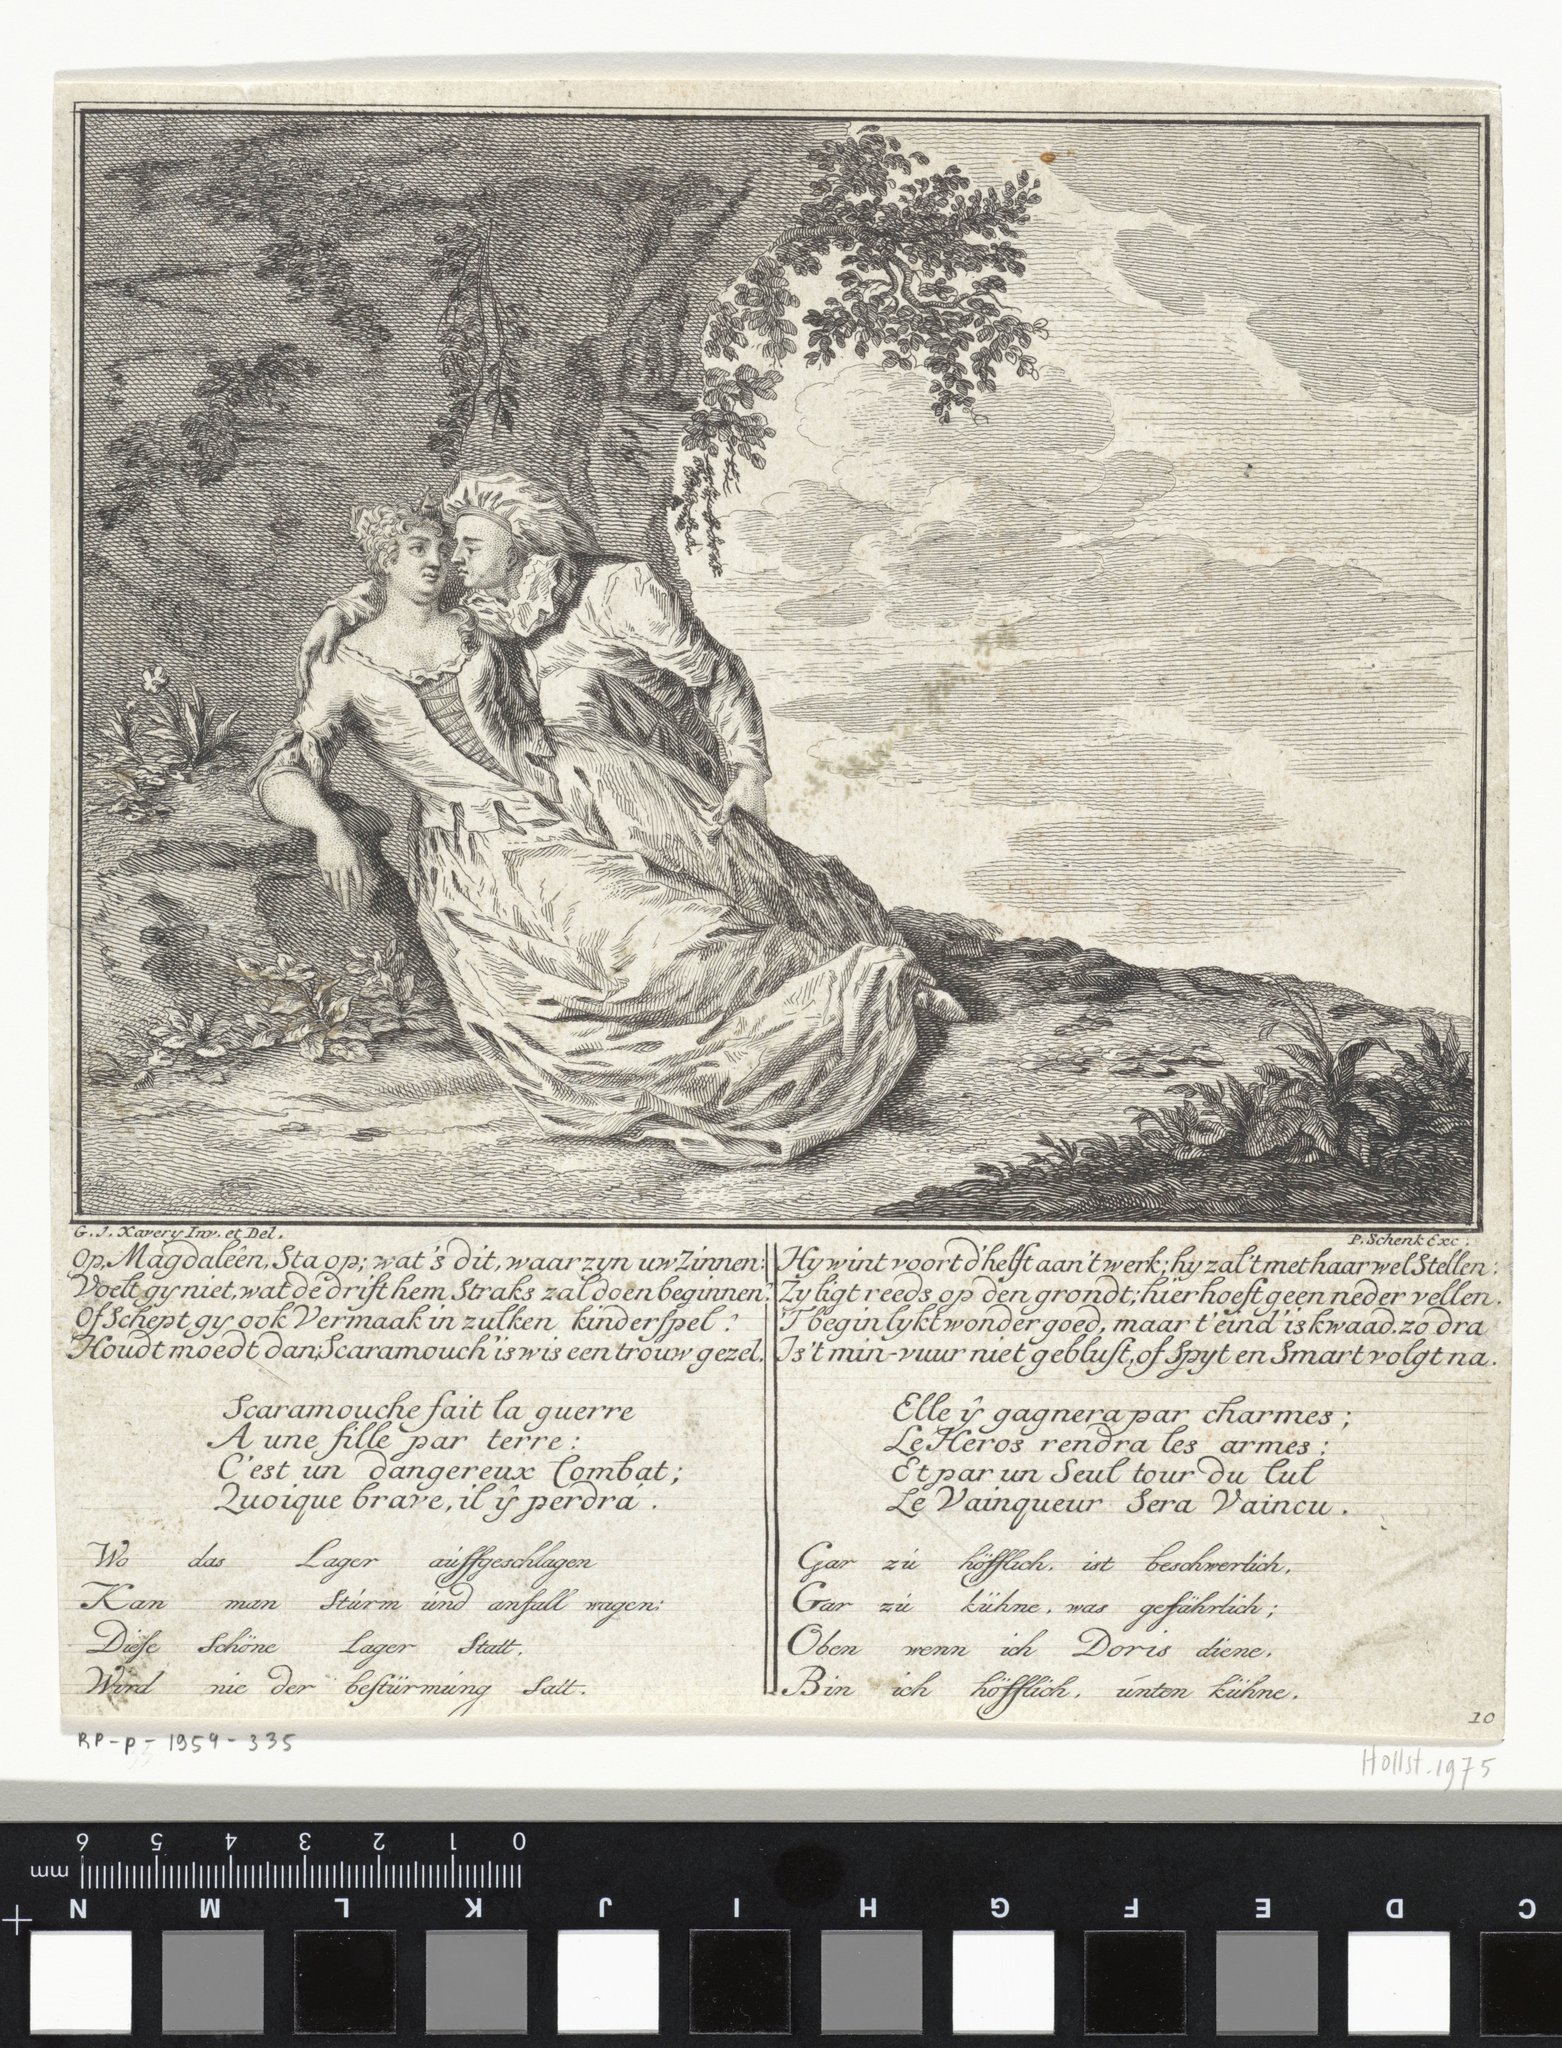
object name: print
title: Scènes uit het Italiaanse theater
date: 1675-1711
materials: paper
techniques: engraving, etching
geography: amsterdam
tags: landscapes, types in 'commedia dell'arte' (with name), embracing each other, kissing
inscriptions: collector's mark: Lugt 2228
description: Scaramouche, een personage uit commedia dell'arte, staat op het punt om Magdaleen te kussen.